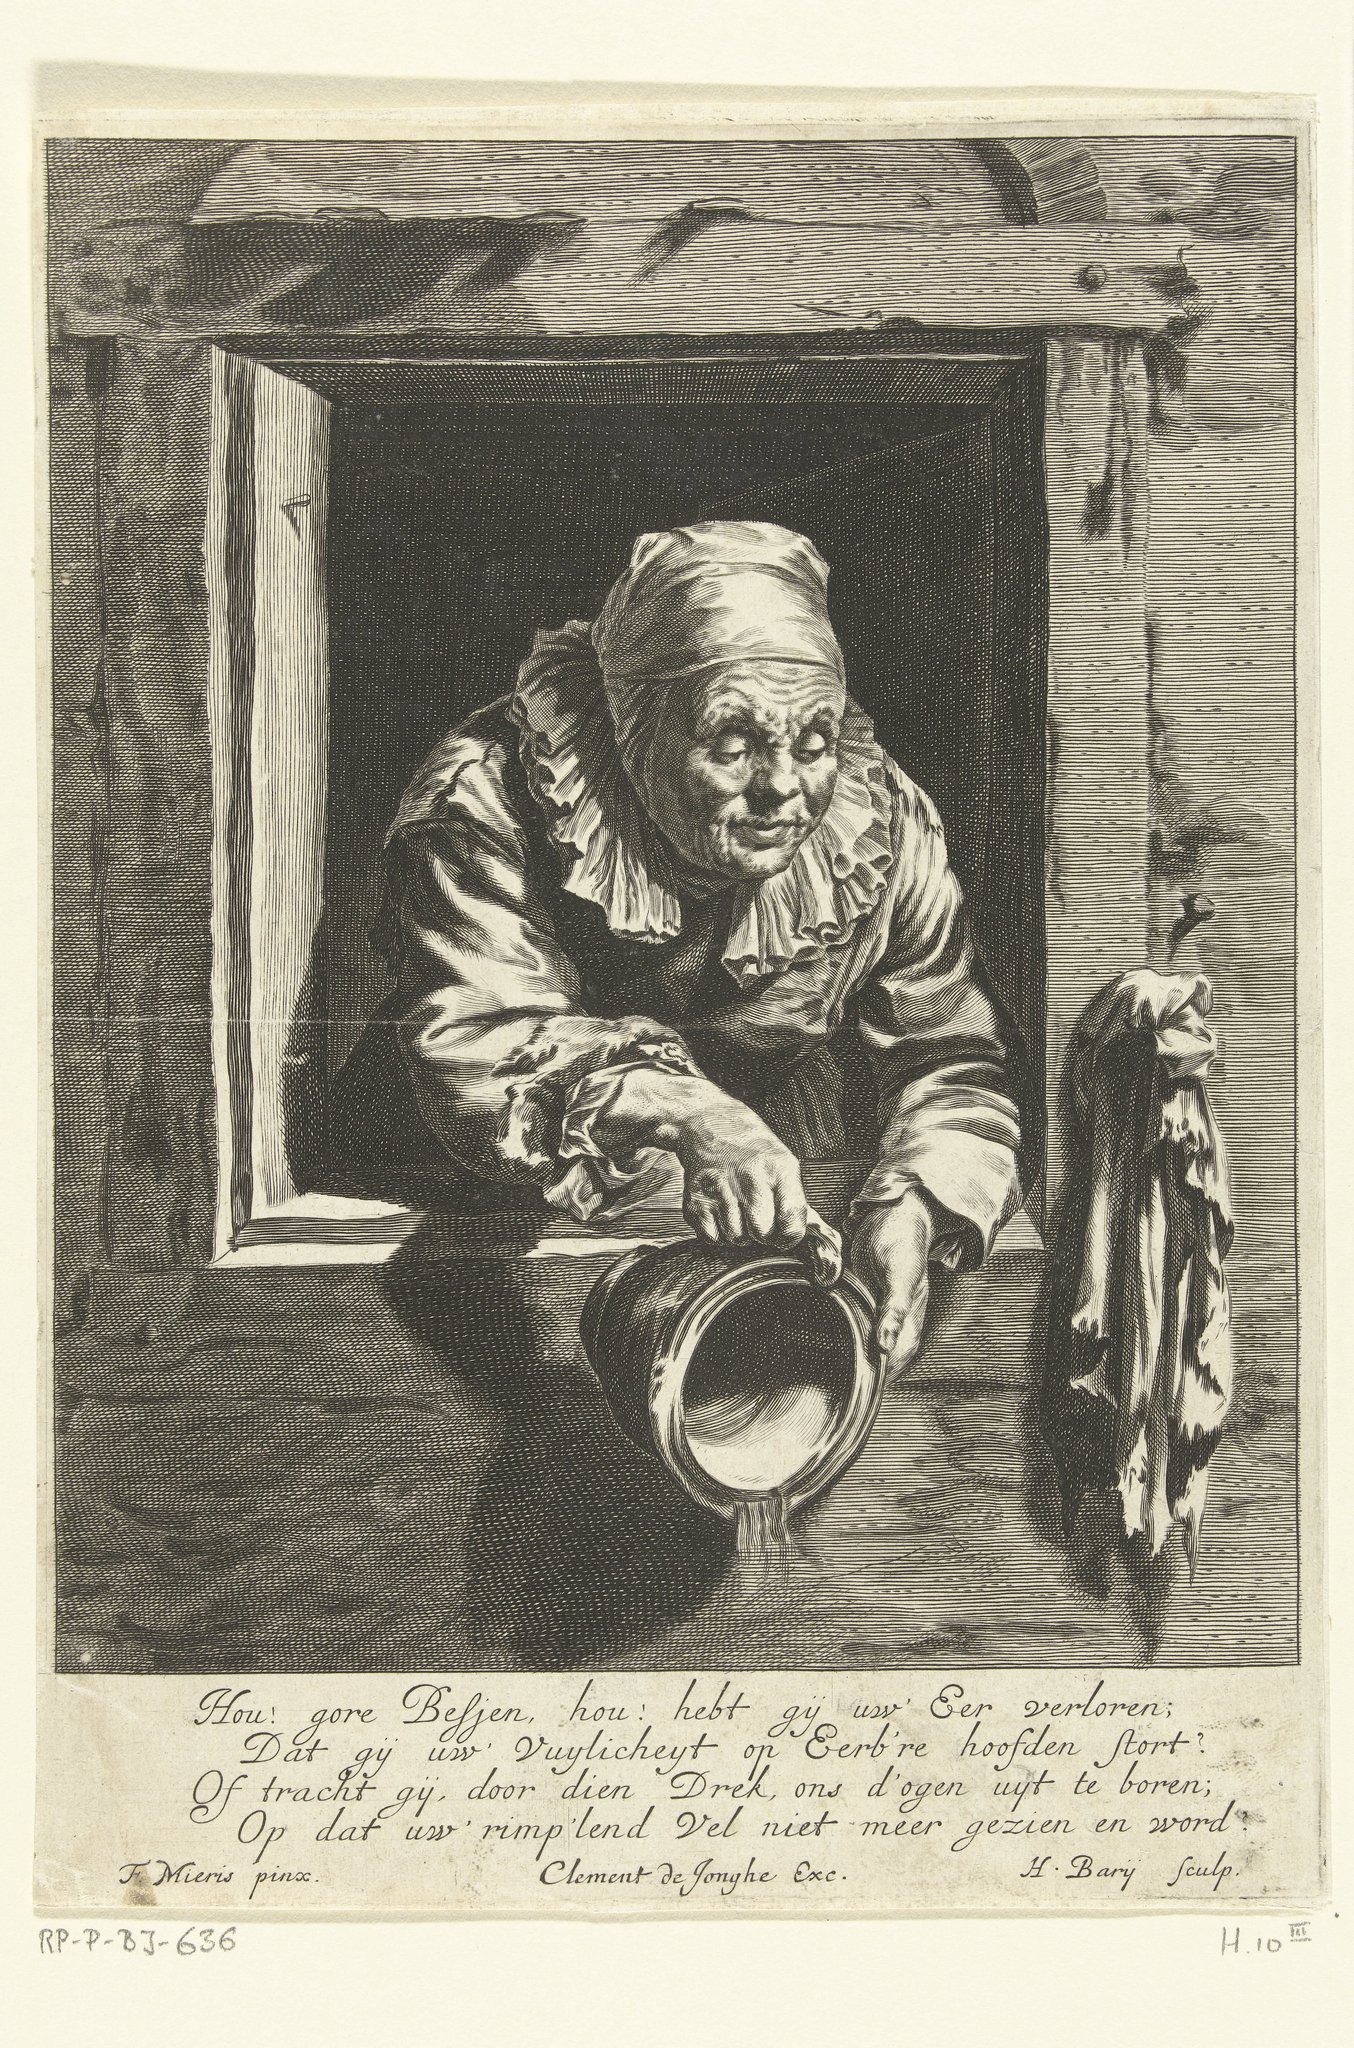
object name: print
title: Gore Besje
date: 1657-1670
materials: paper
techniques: engraving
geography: netherlands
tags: old woman, chamber-pot, chamber-pot is emptied from above ~ chasing away (unwanted) lover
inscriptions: collector's mark: Lugt 2228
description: Een oude vrouw gooit de inhoud van haar pispot uit het raam. Onder de voorstelling een vers van vier regels in het Nederlands.